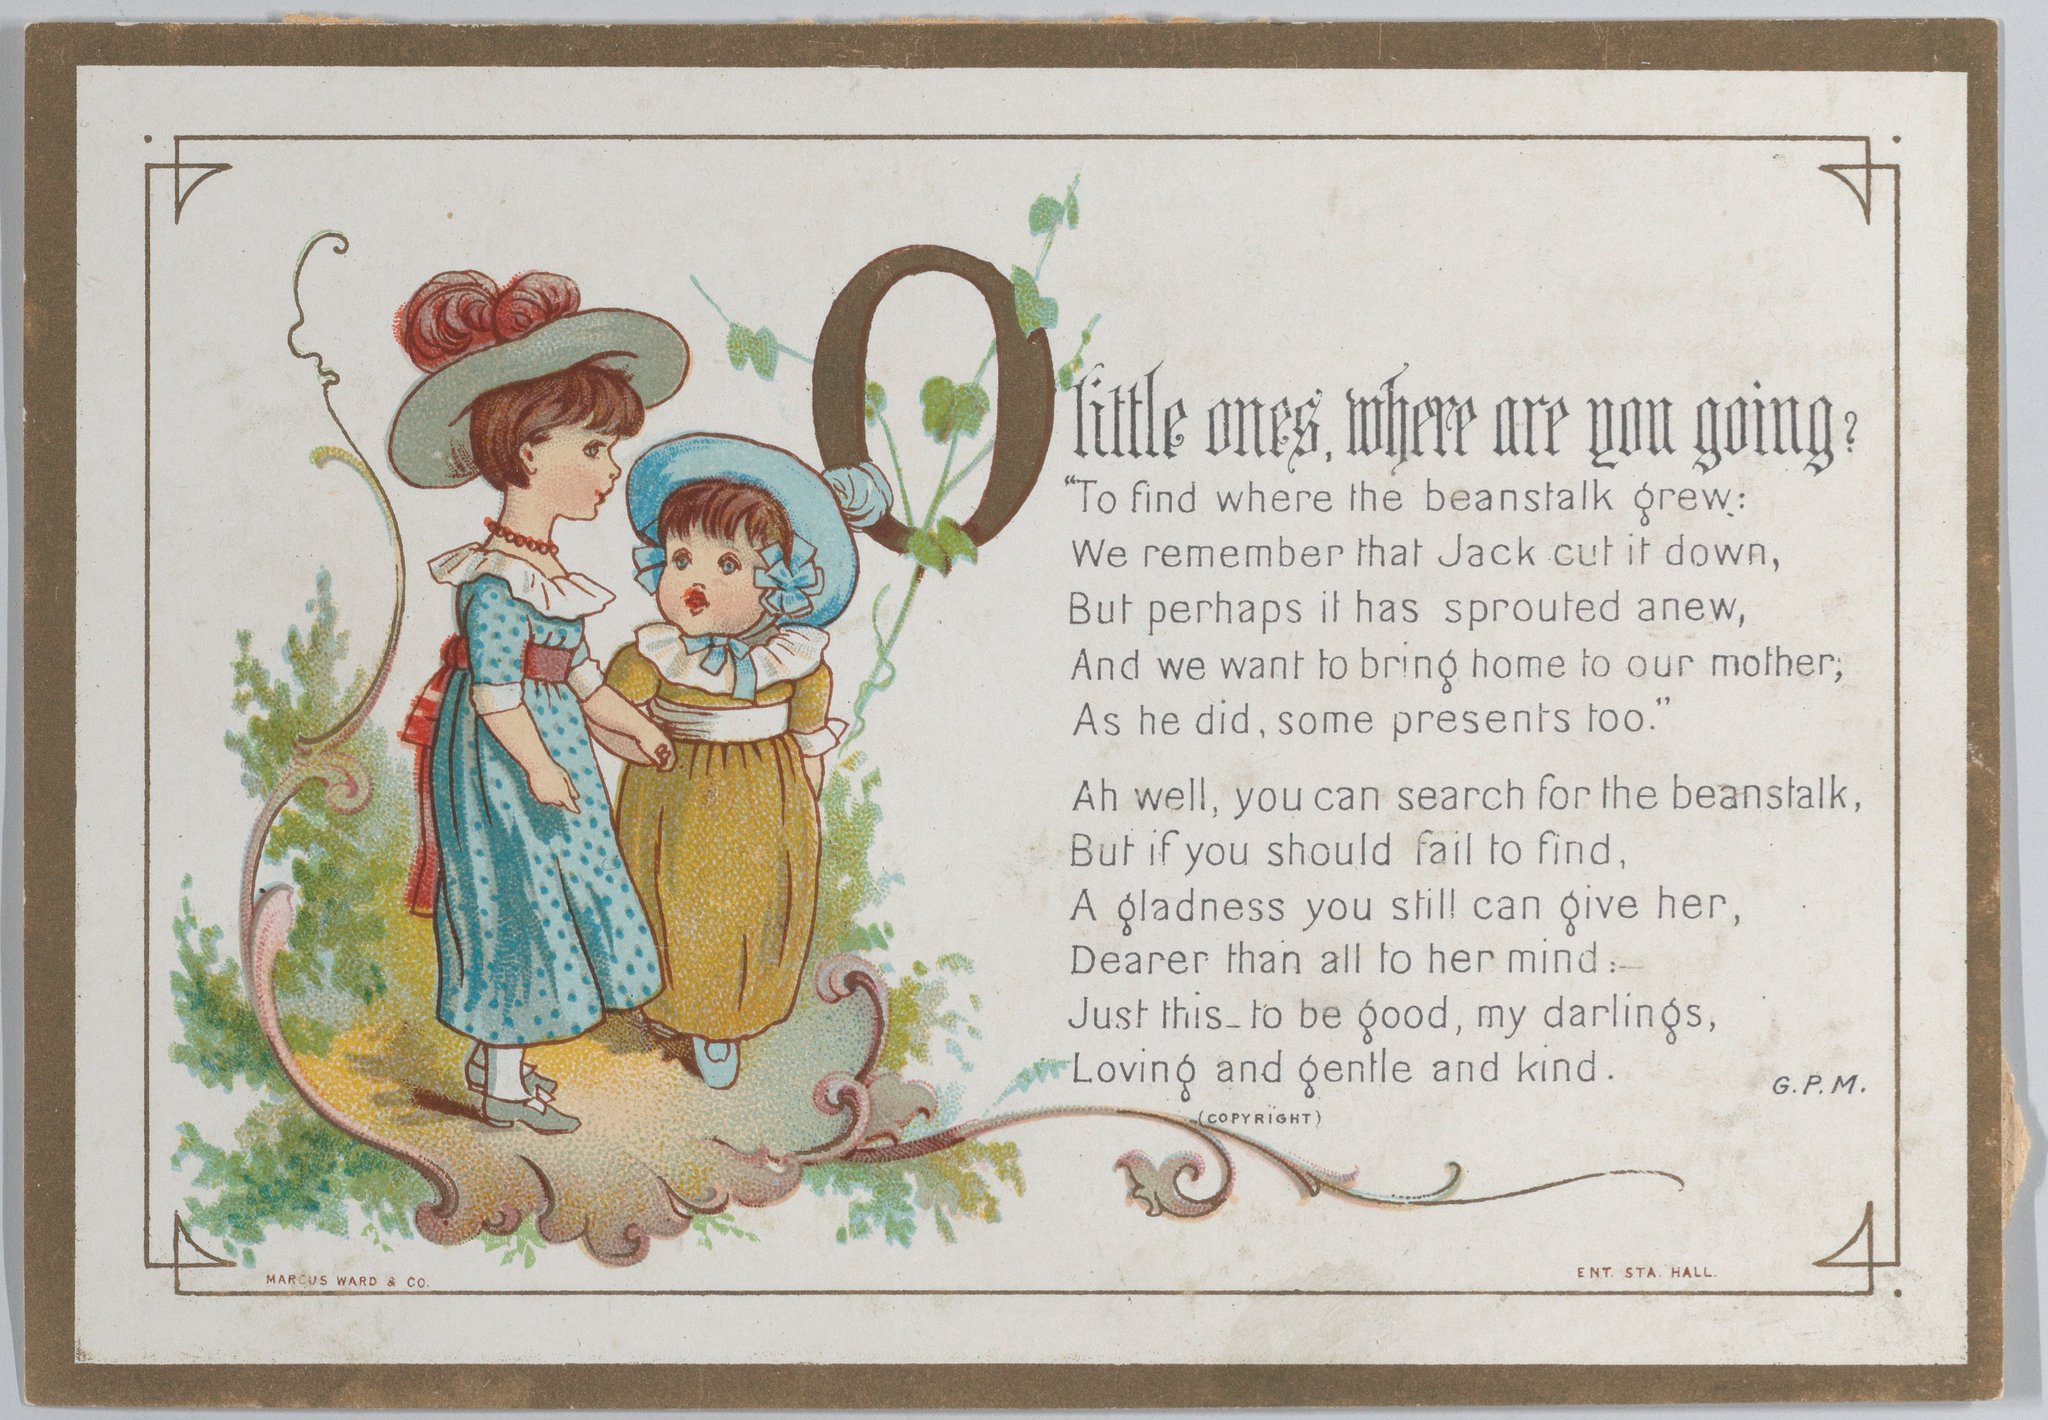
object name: valentine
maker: kate greenaway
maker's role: artist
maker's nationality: british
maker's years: 1846-1901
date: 1877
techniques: chromolithography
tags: girls